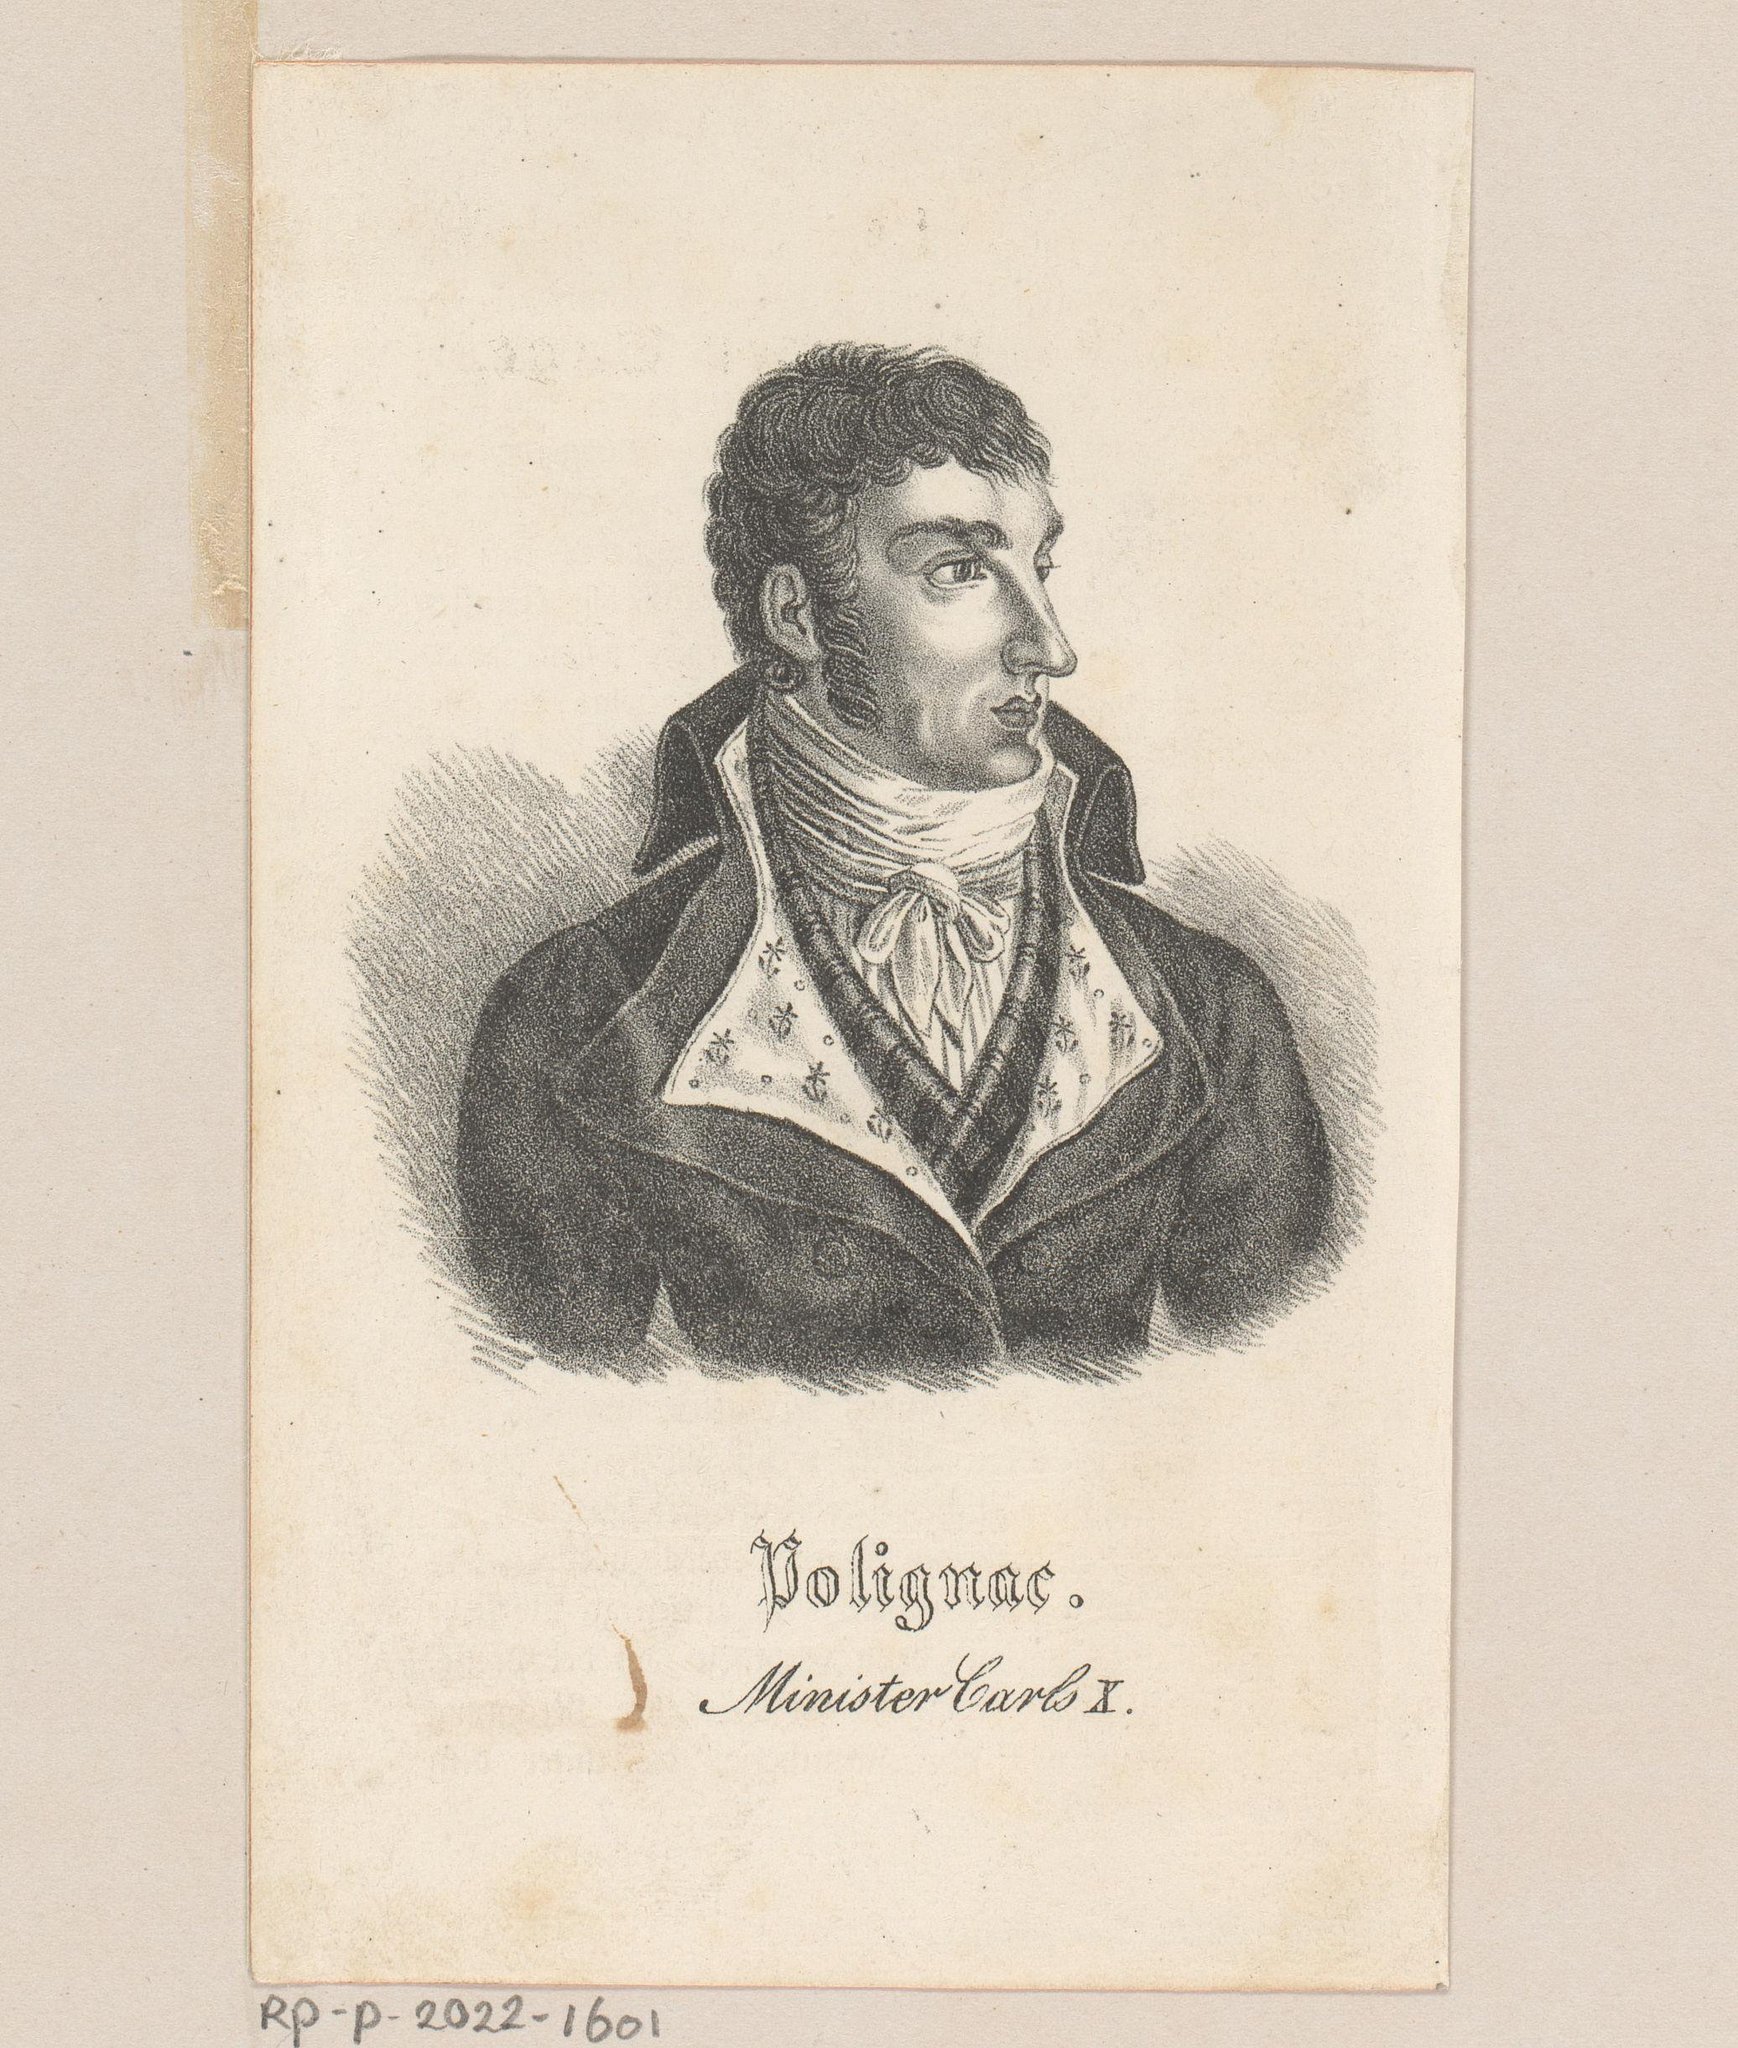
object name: print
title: Portret van Jules de Polignac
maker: Anonymous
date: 1820-1899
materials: paper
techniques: lithograph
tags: politician, historical persons, politician, e.g. party leader